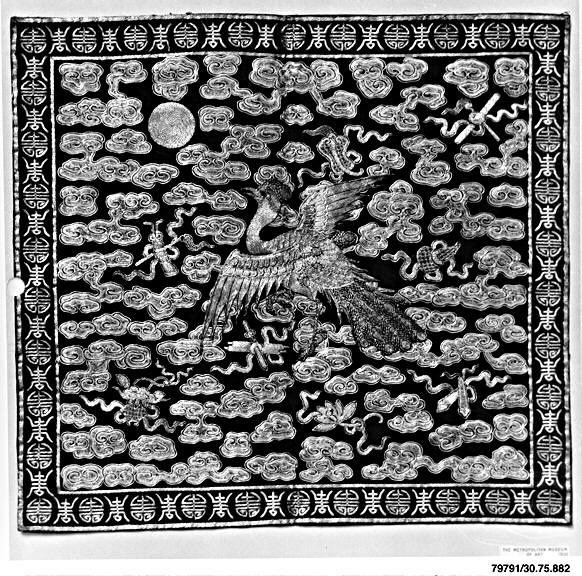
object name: rank badge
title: Rank Badge with Peacock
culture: chinese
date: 1801-1900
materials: metal thread, silk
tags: peacocks